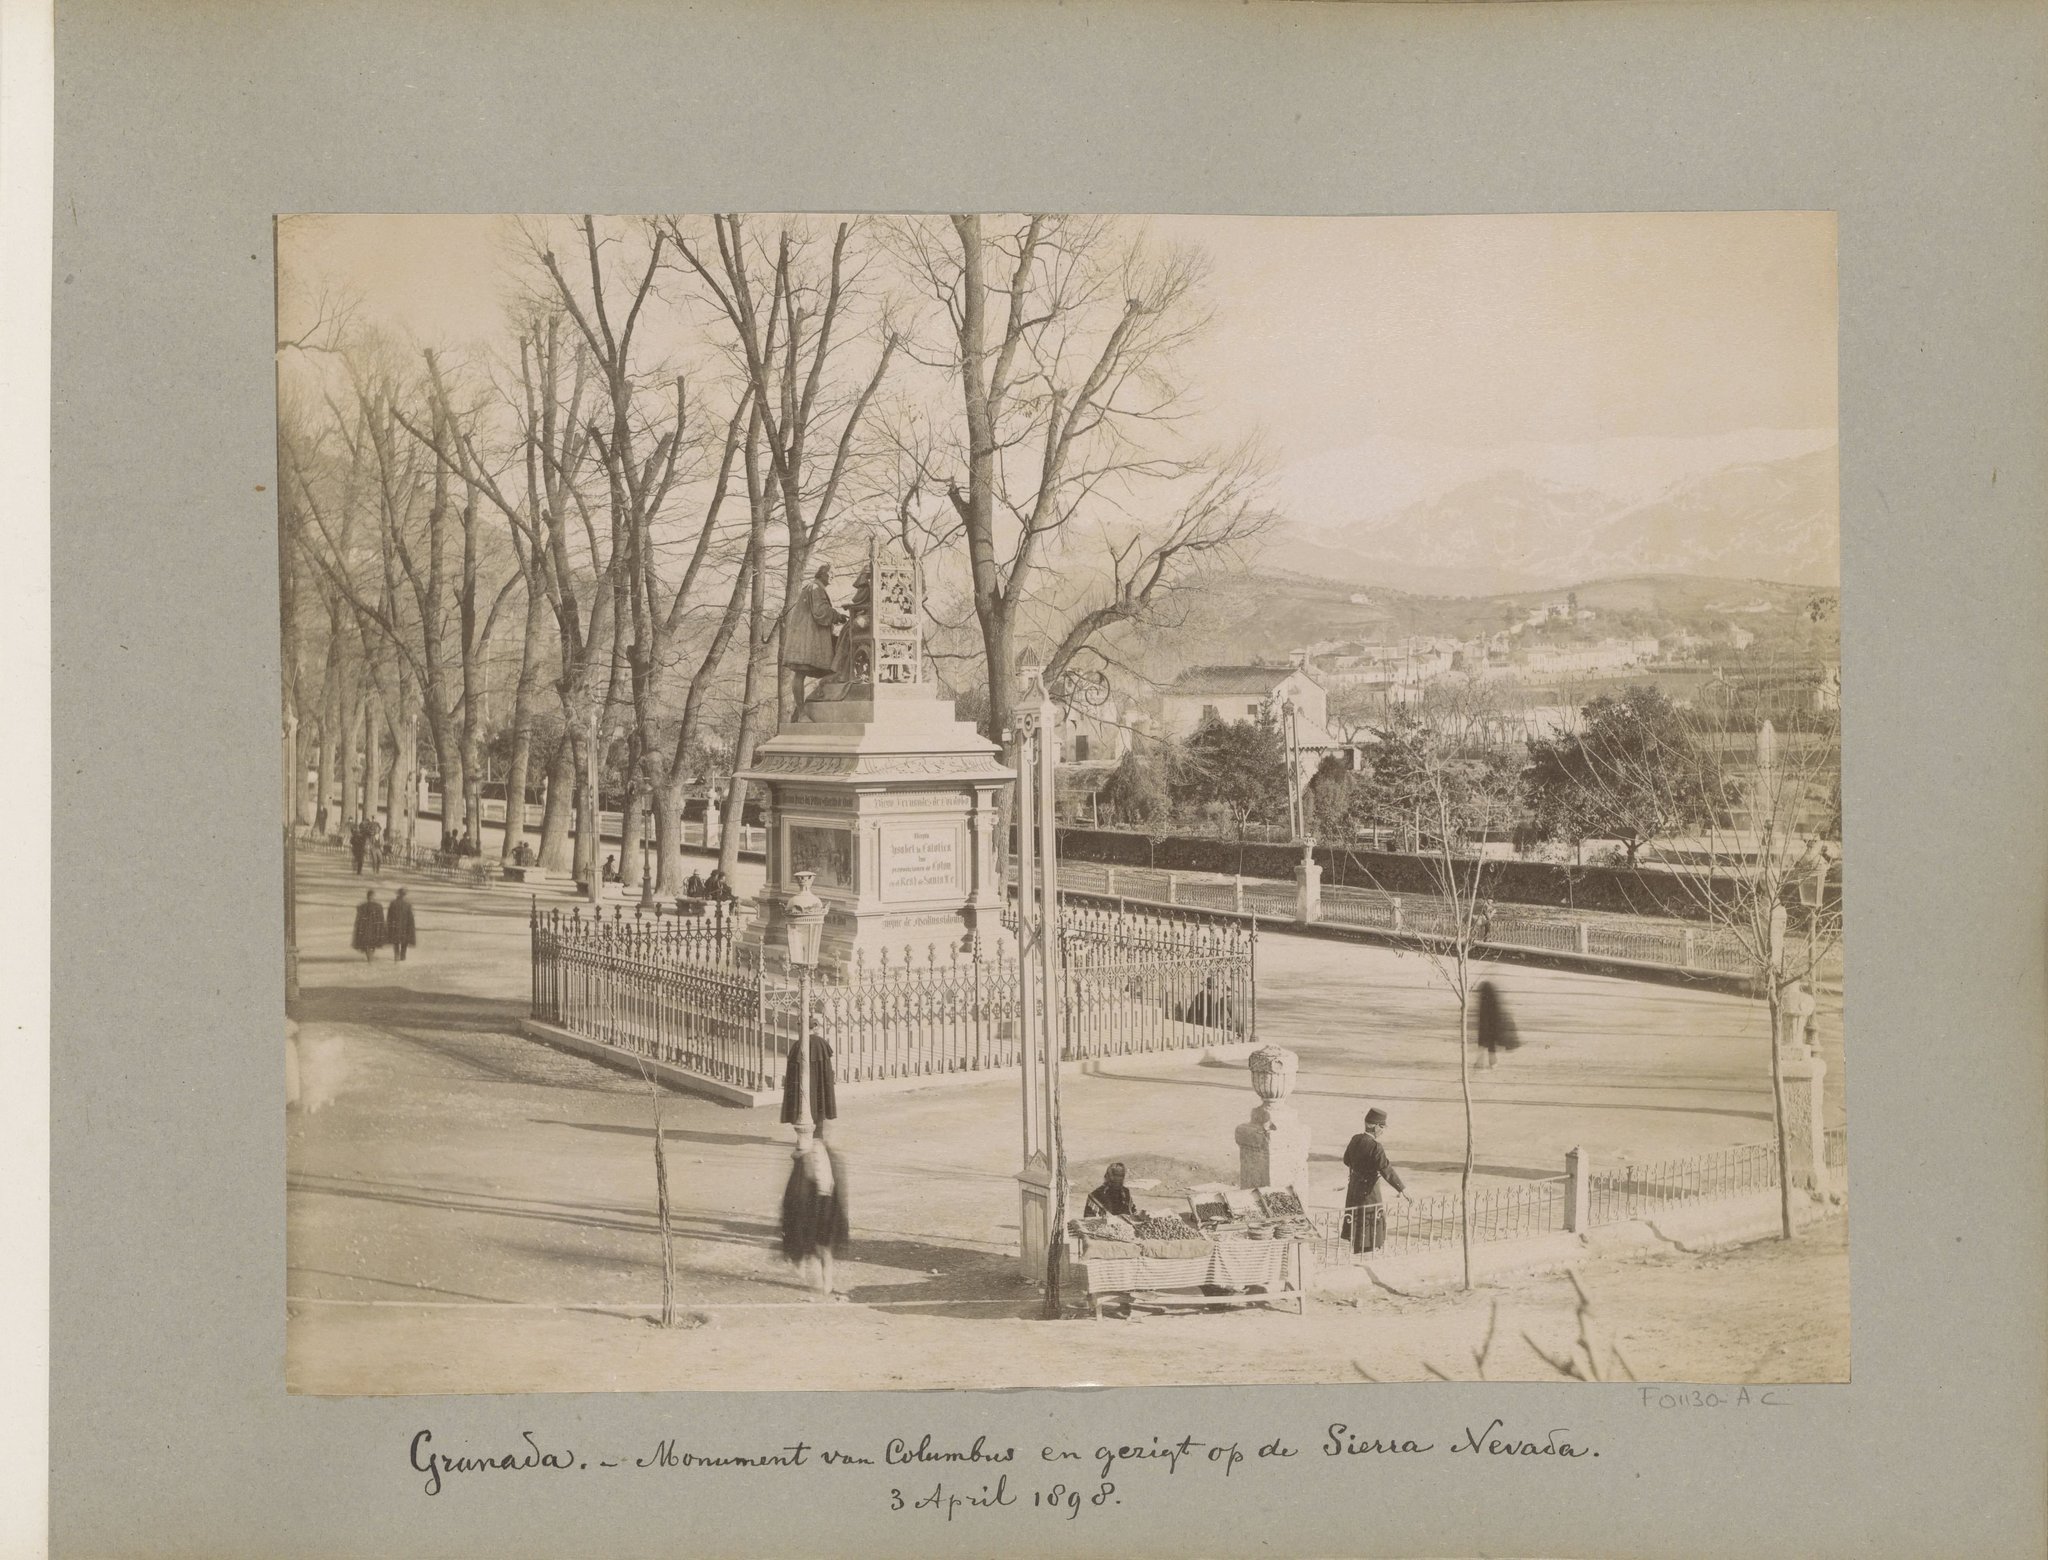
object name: photograph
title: Monument van Isabella I van Castilië met Columbus in Granada, met op de achtergrond de Sierra Nevada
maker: rafael garzón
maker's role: publisher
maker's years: 1863-1923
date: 1880-1898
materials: paper, photographic support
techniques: albumen print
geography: granada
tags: monument, statue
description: Onderdeel van Reisalbum met foto's van bezienswaardigheden in Frankrijk, Spanje, Italië, Duitsland, Zwitserland en Oostenrijk.